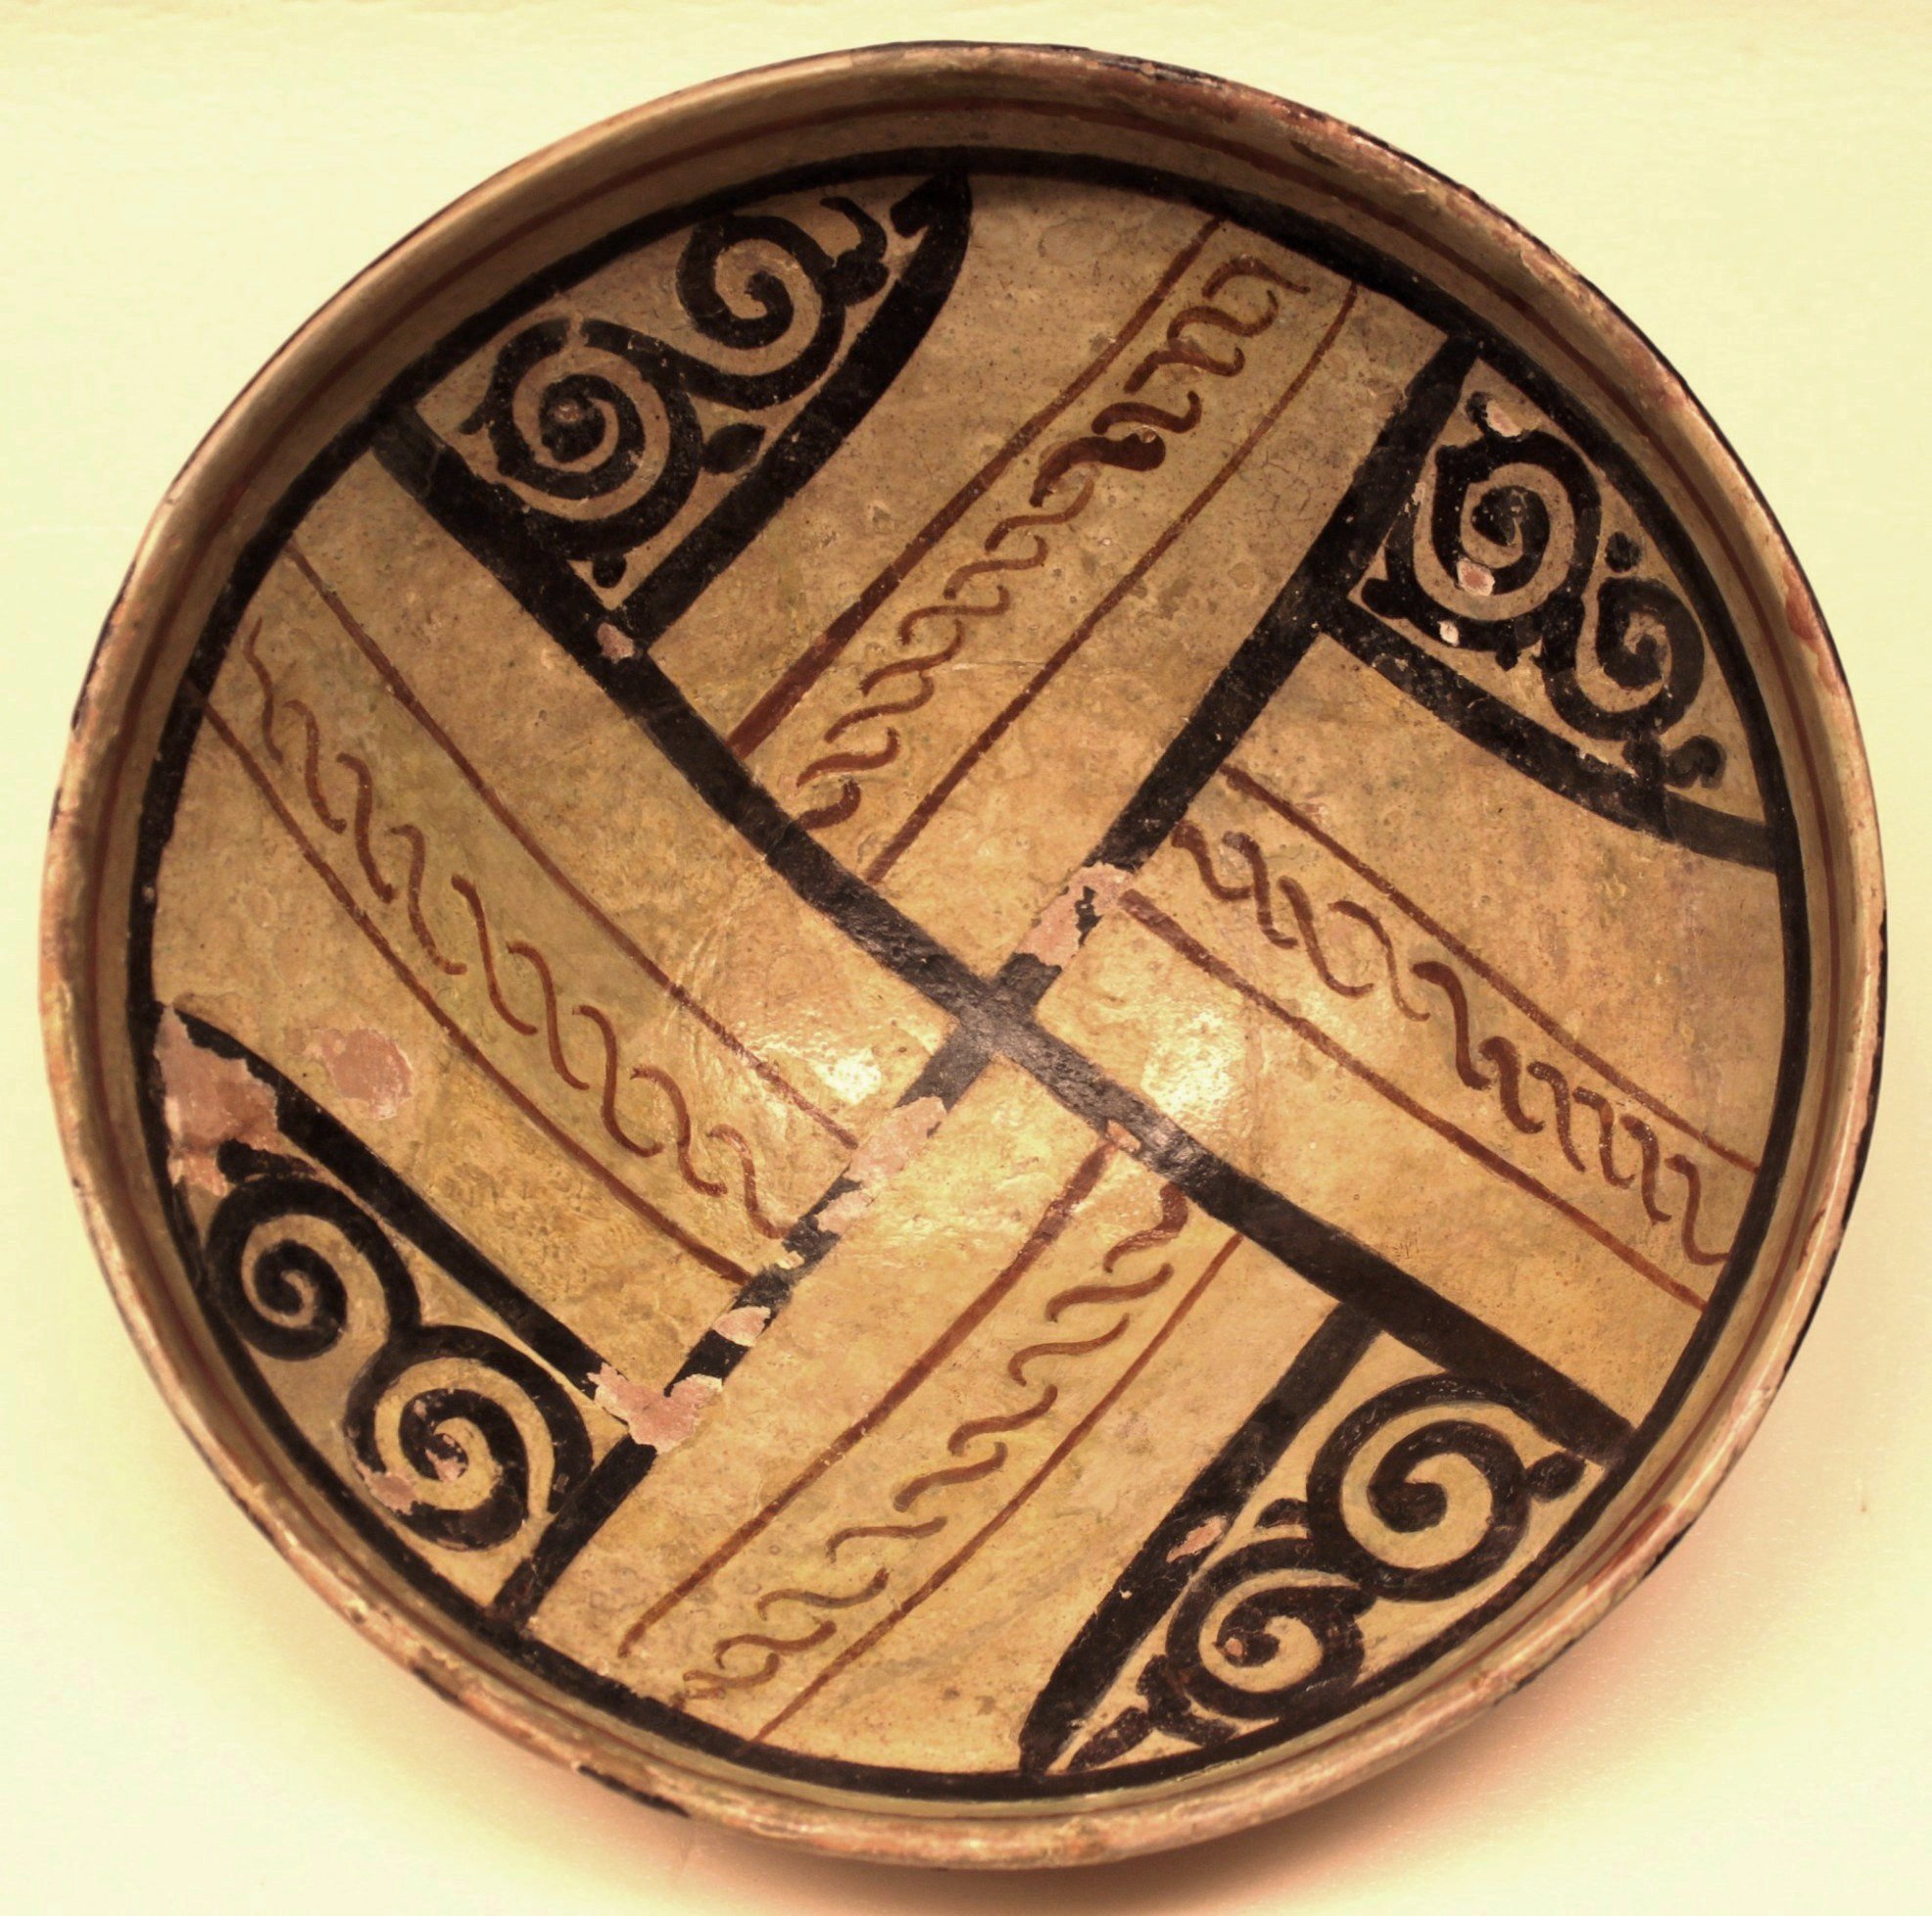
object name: bowl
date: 901-1000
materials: earthenware, glaze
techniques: polychrome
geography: iran